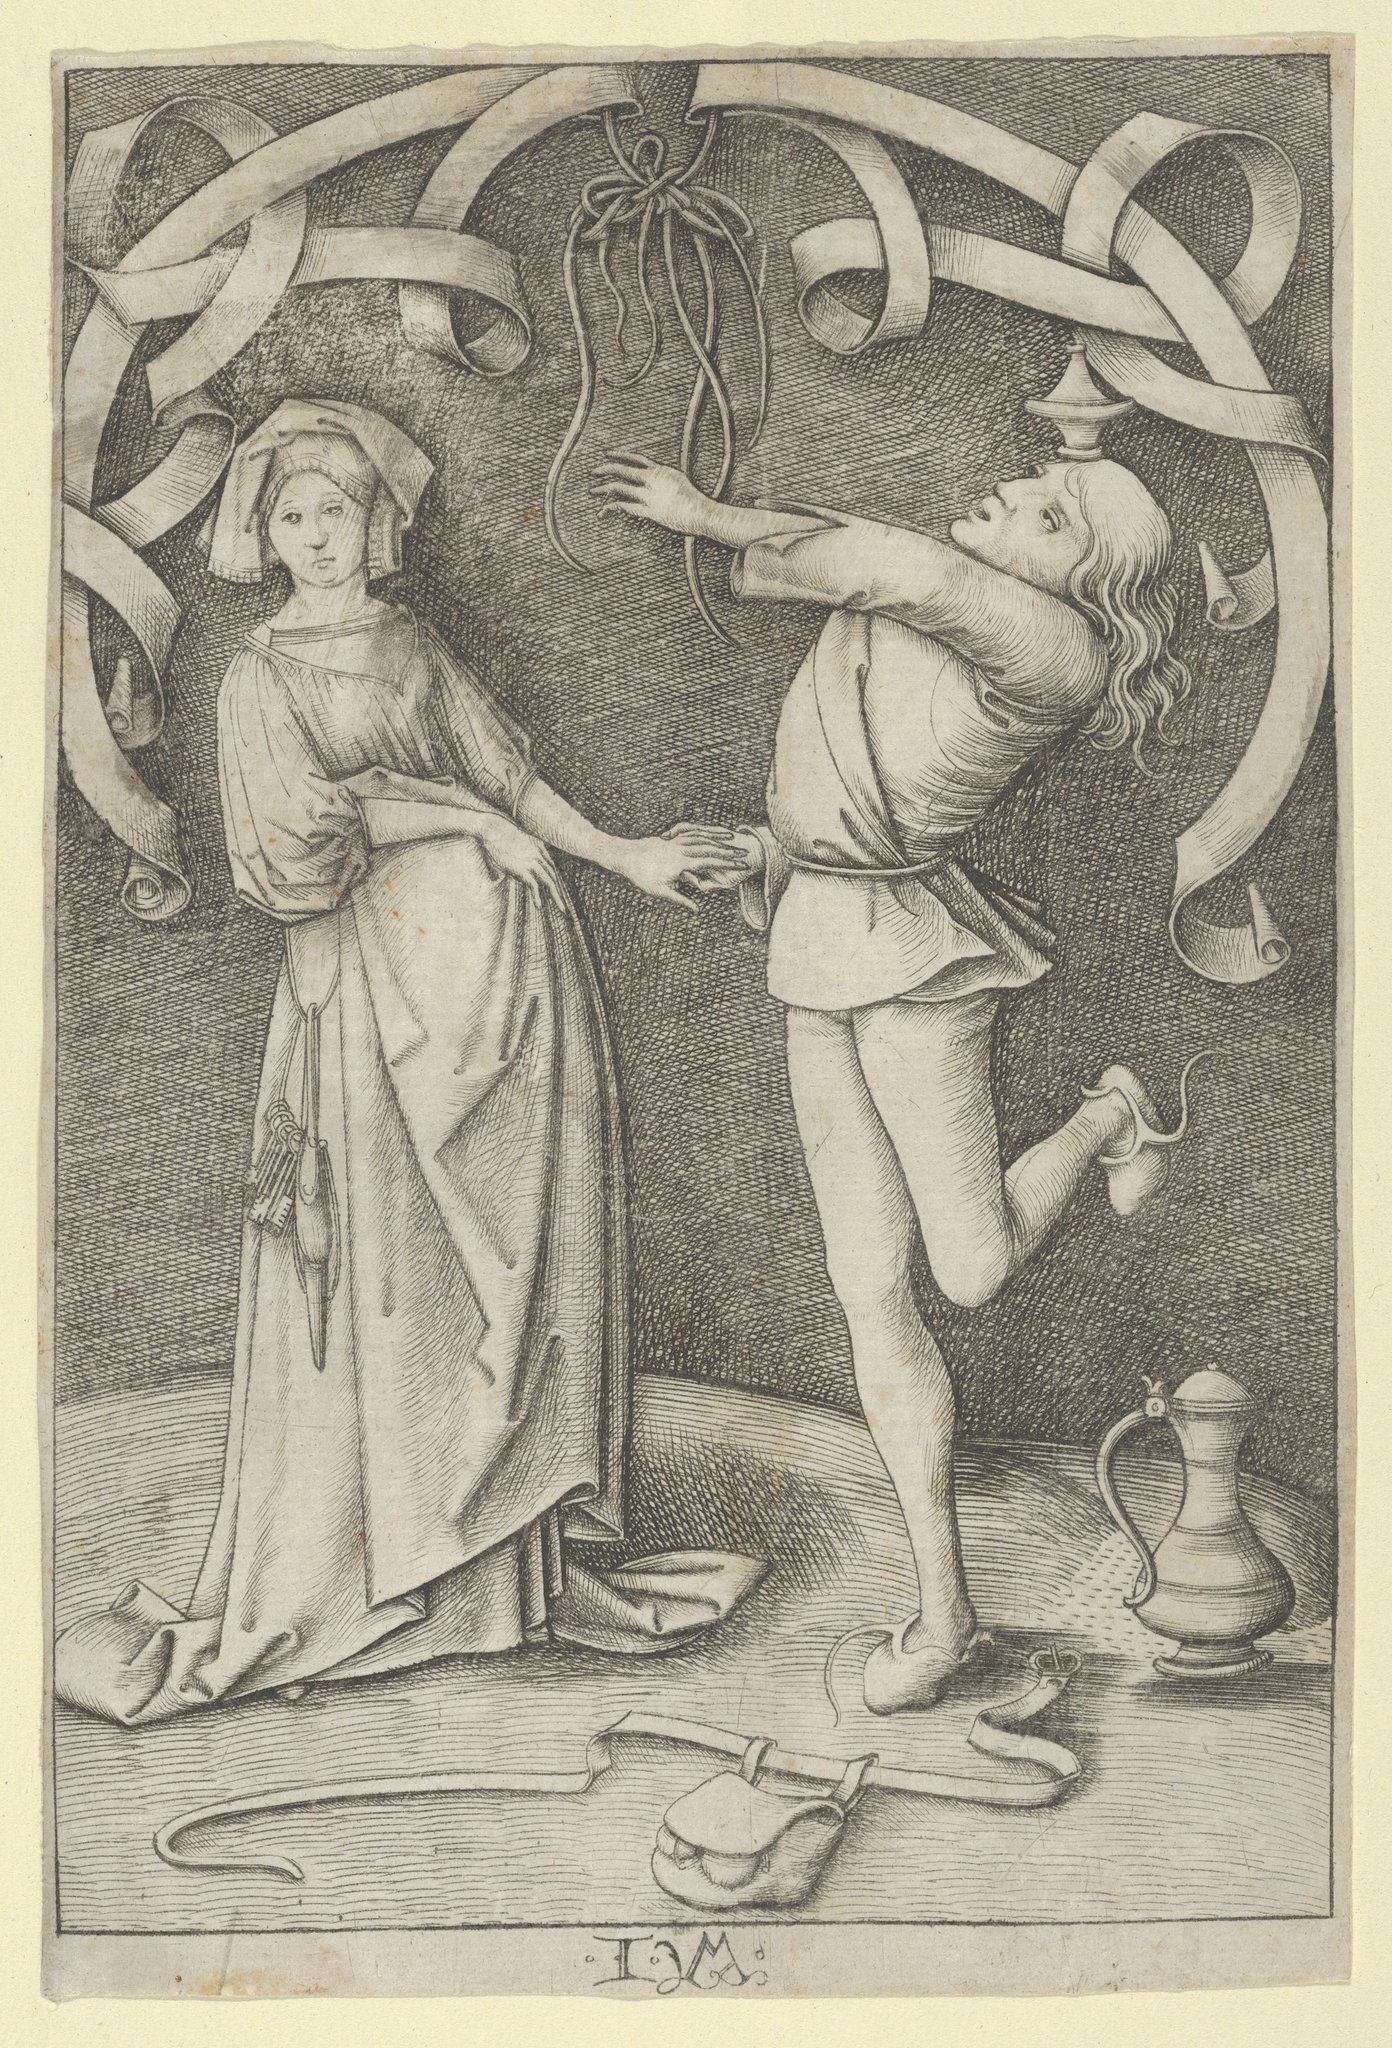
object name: print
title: The Fool and the Lady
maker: israhel van meckenem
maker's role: artist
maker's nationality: german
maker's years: 1435-1503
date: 1450-1503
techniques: engraving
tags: men,women